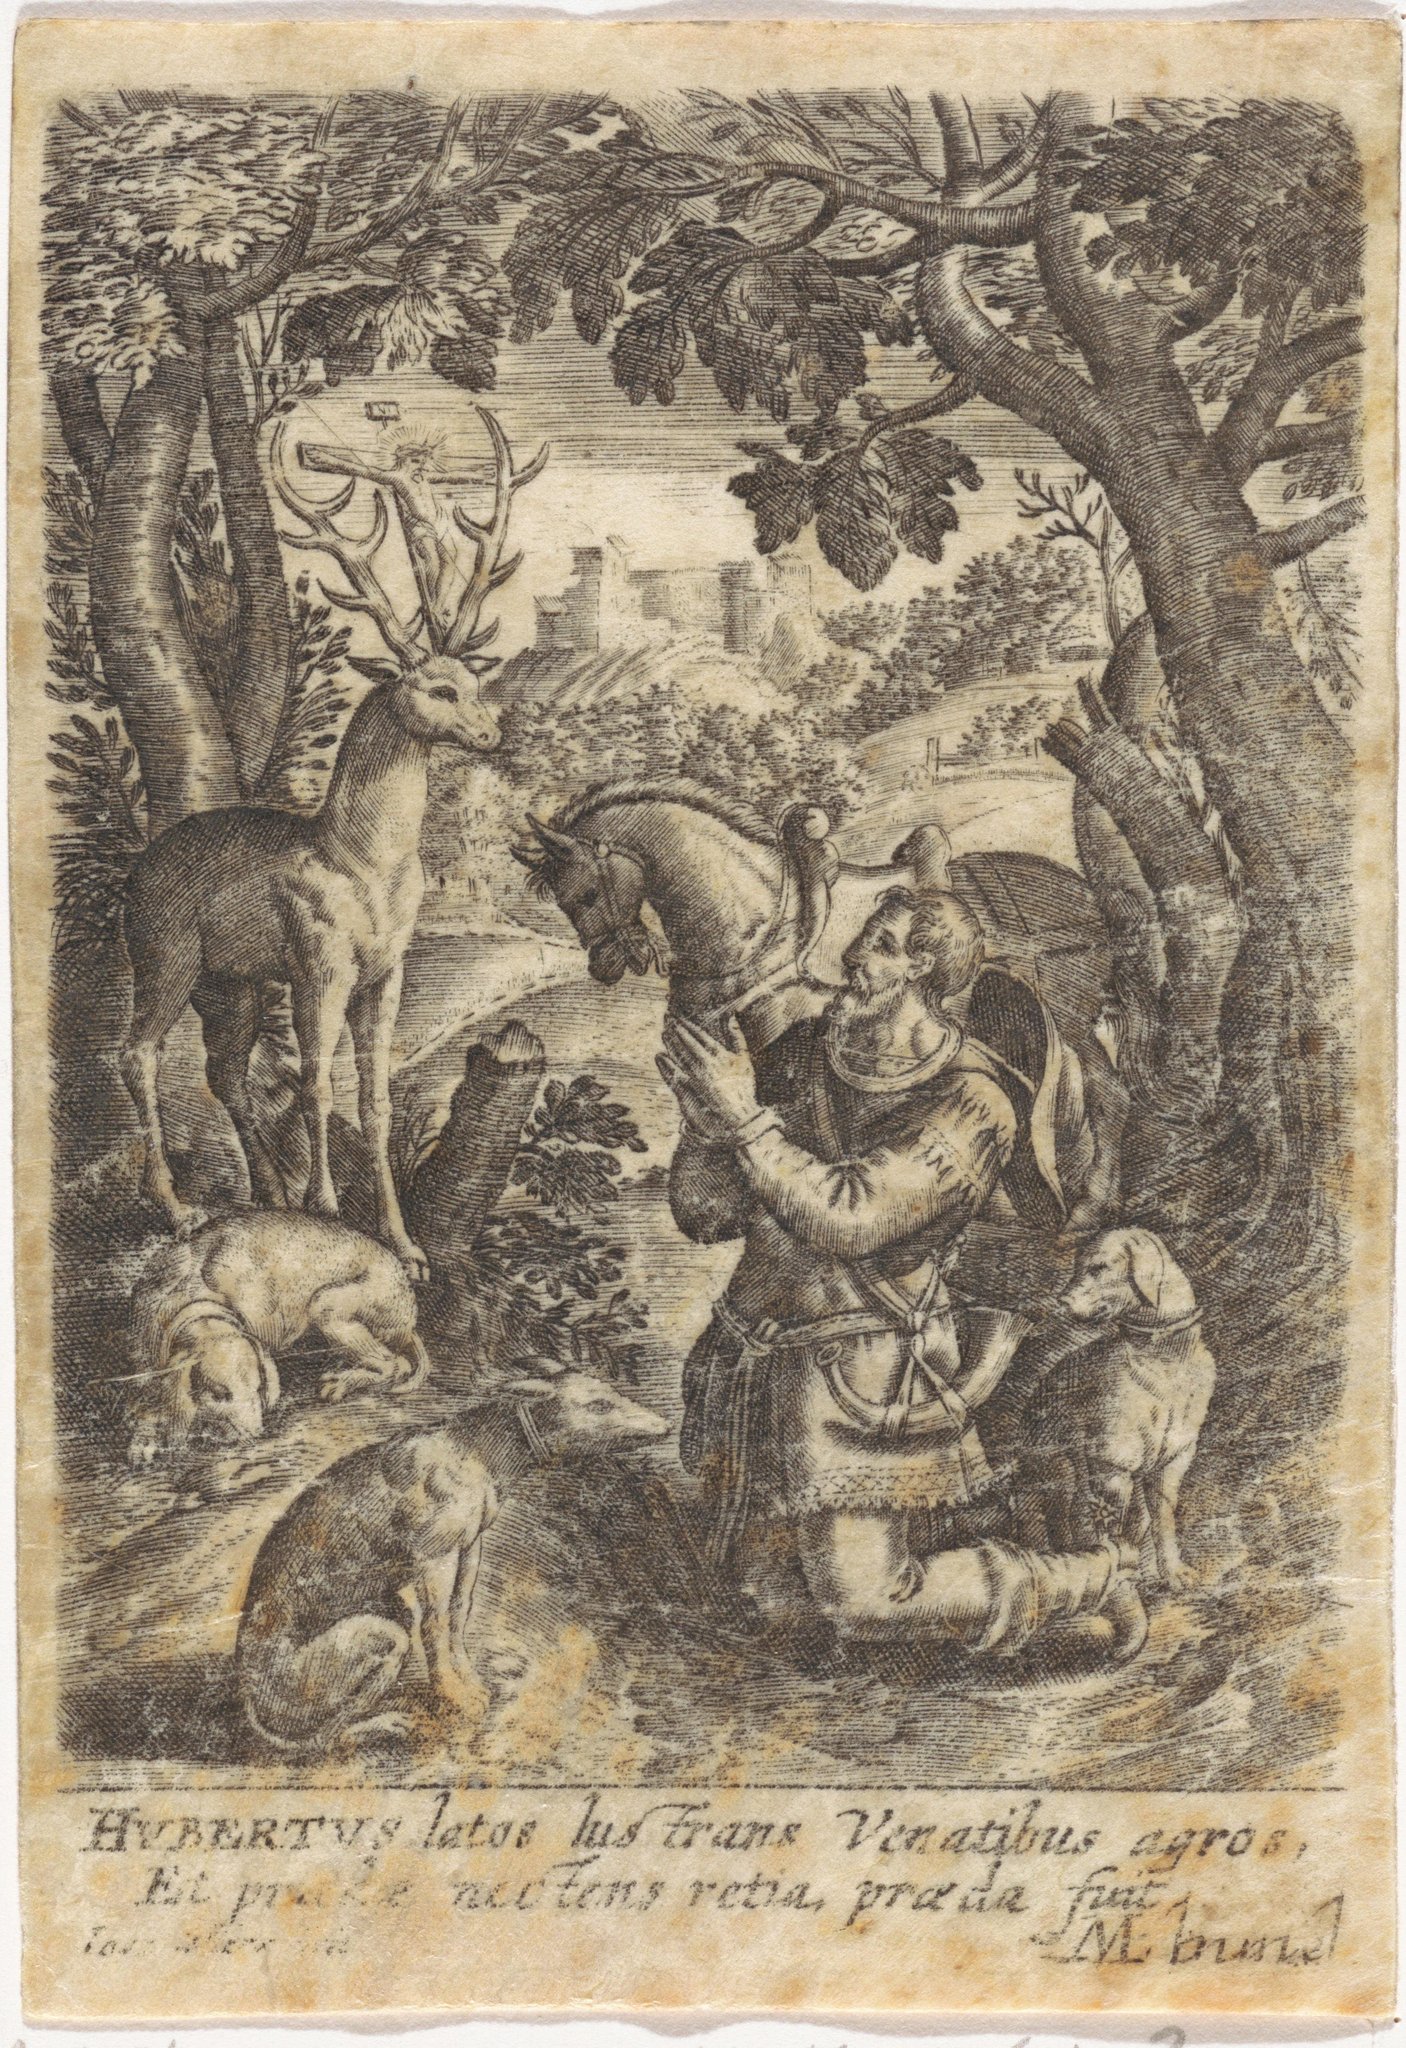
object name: print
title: Bekering van H. Hubertus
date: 1680-1739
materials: parchment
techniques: engraving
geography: antwerp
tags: while hunting on good friday st. hubert is confronted with a white stag bearing a crucifix between its antlers; hubert kneels before the stag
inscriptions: collector's mark: Lugt 2228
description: De heilige Hubertus knielt in het bos voor een hertenbok met een crucifix tussen zijn gewei. Rondom hem zijn jachthonden en zijn paard. In de marge een tweeregelig onderschrift in het Latijn.